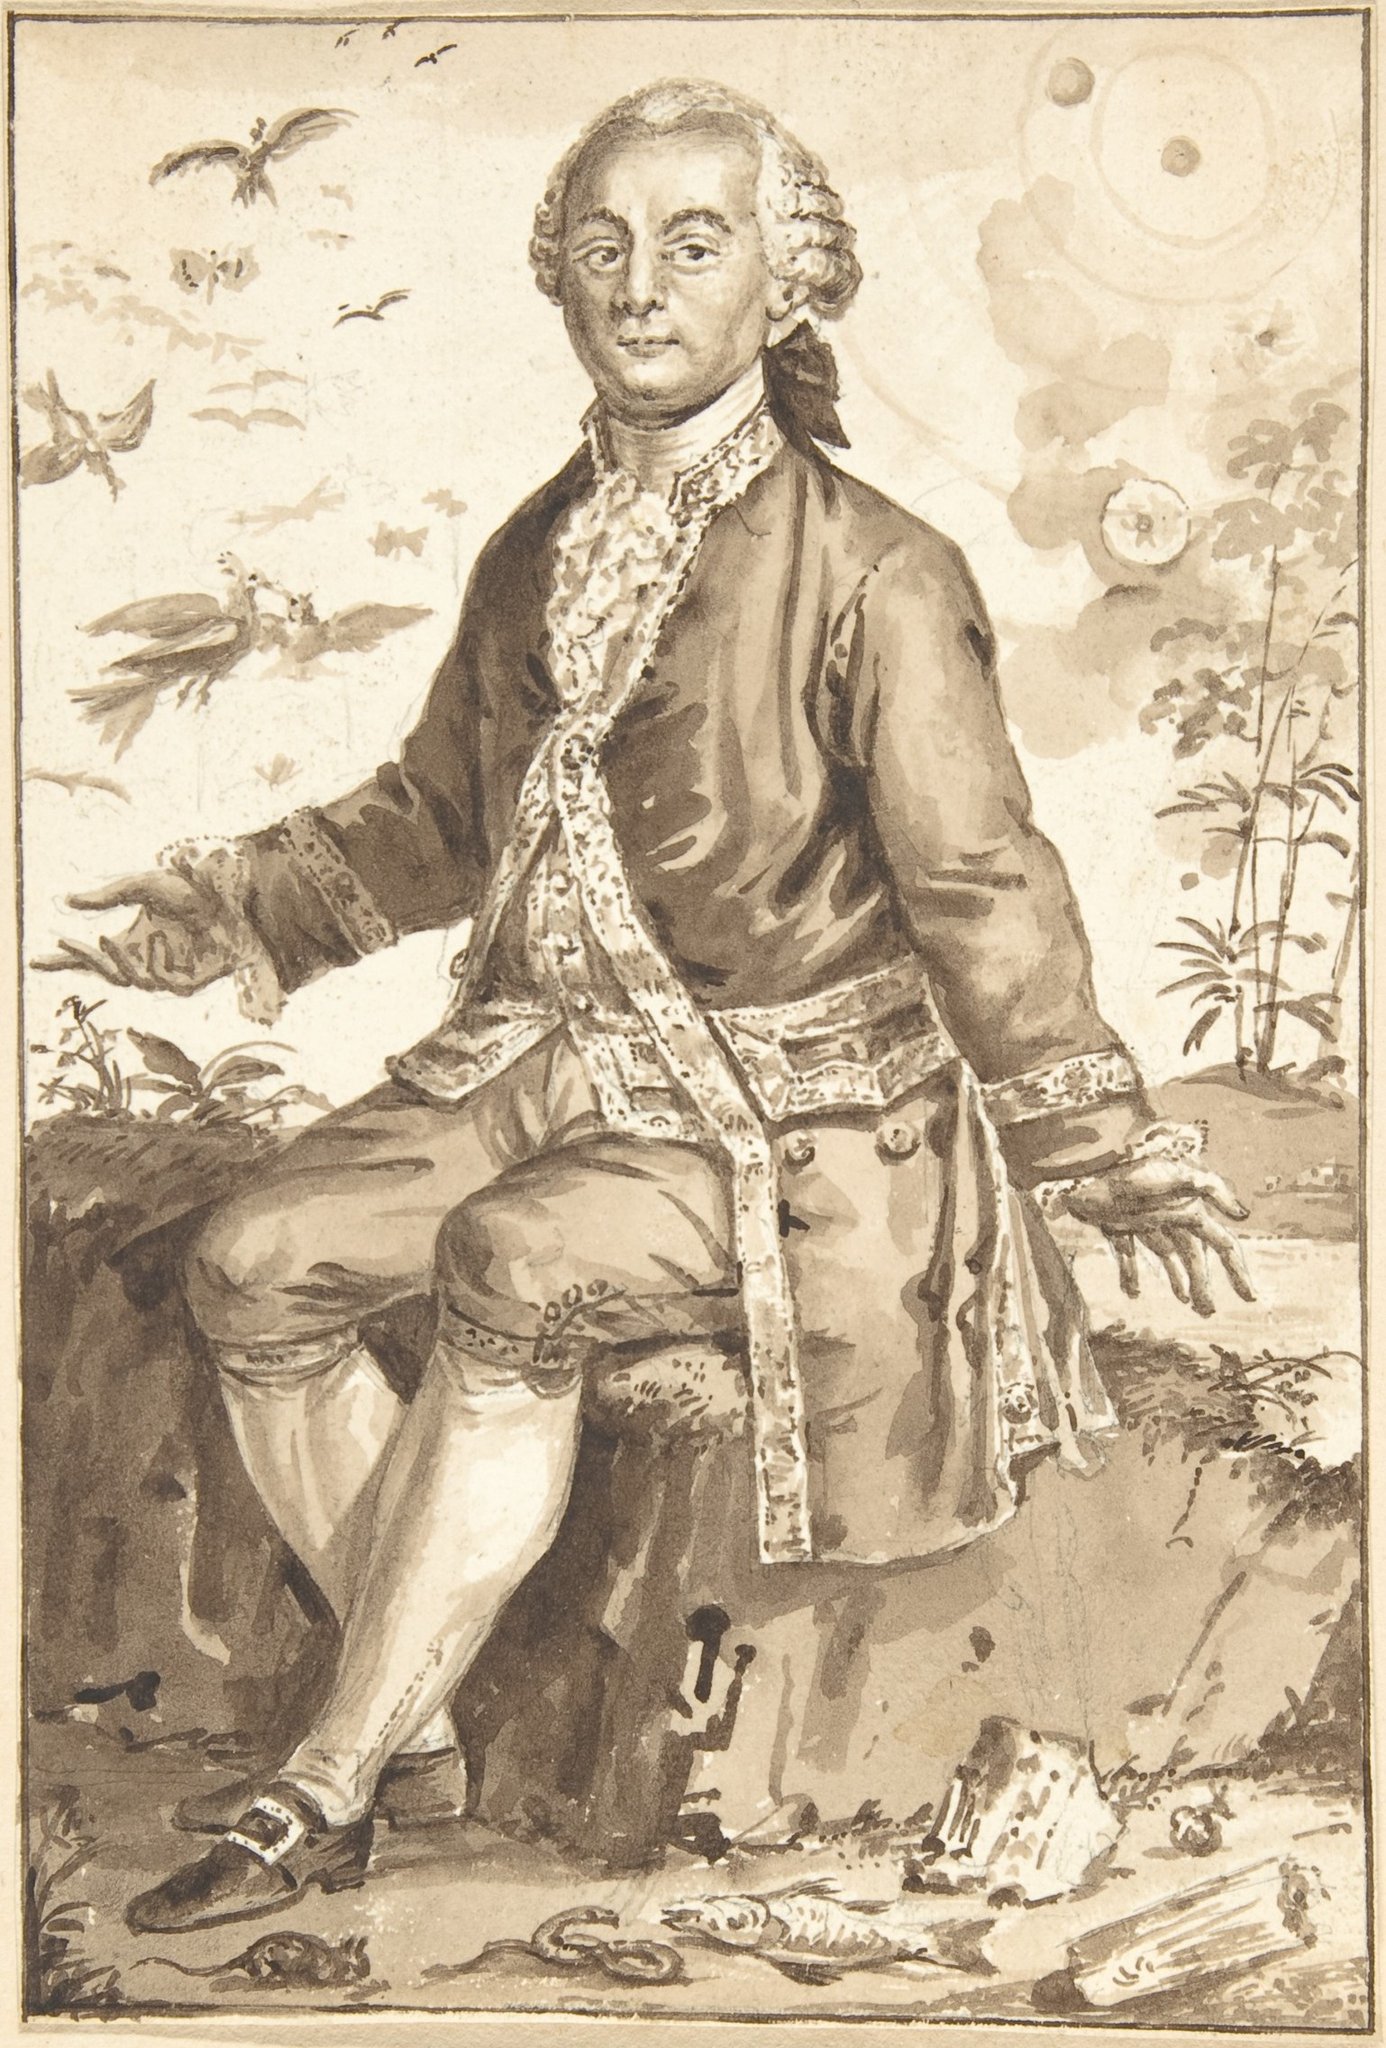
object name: drawing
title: Portrait of G.-L. Leclere, Comte de Buffon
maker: jean-baptiste-françois bosio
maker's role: artist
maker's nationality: french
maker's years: 1764-1827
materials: graphite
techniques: brush, wash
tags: men,portraits